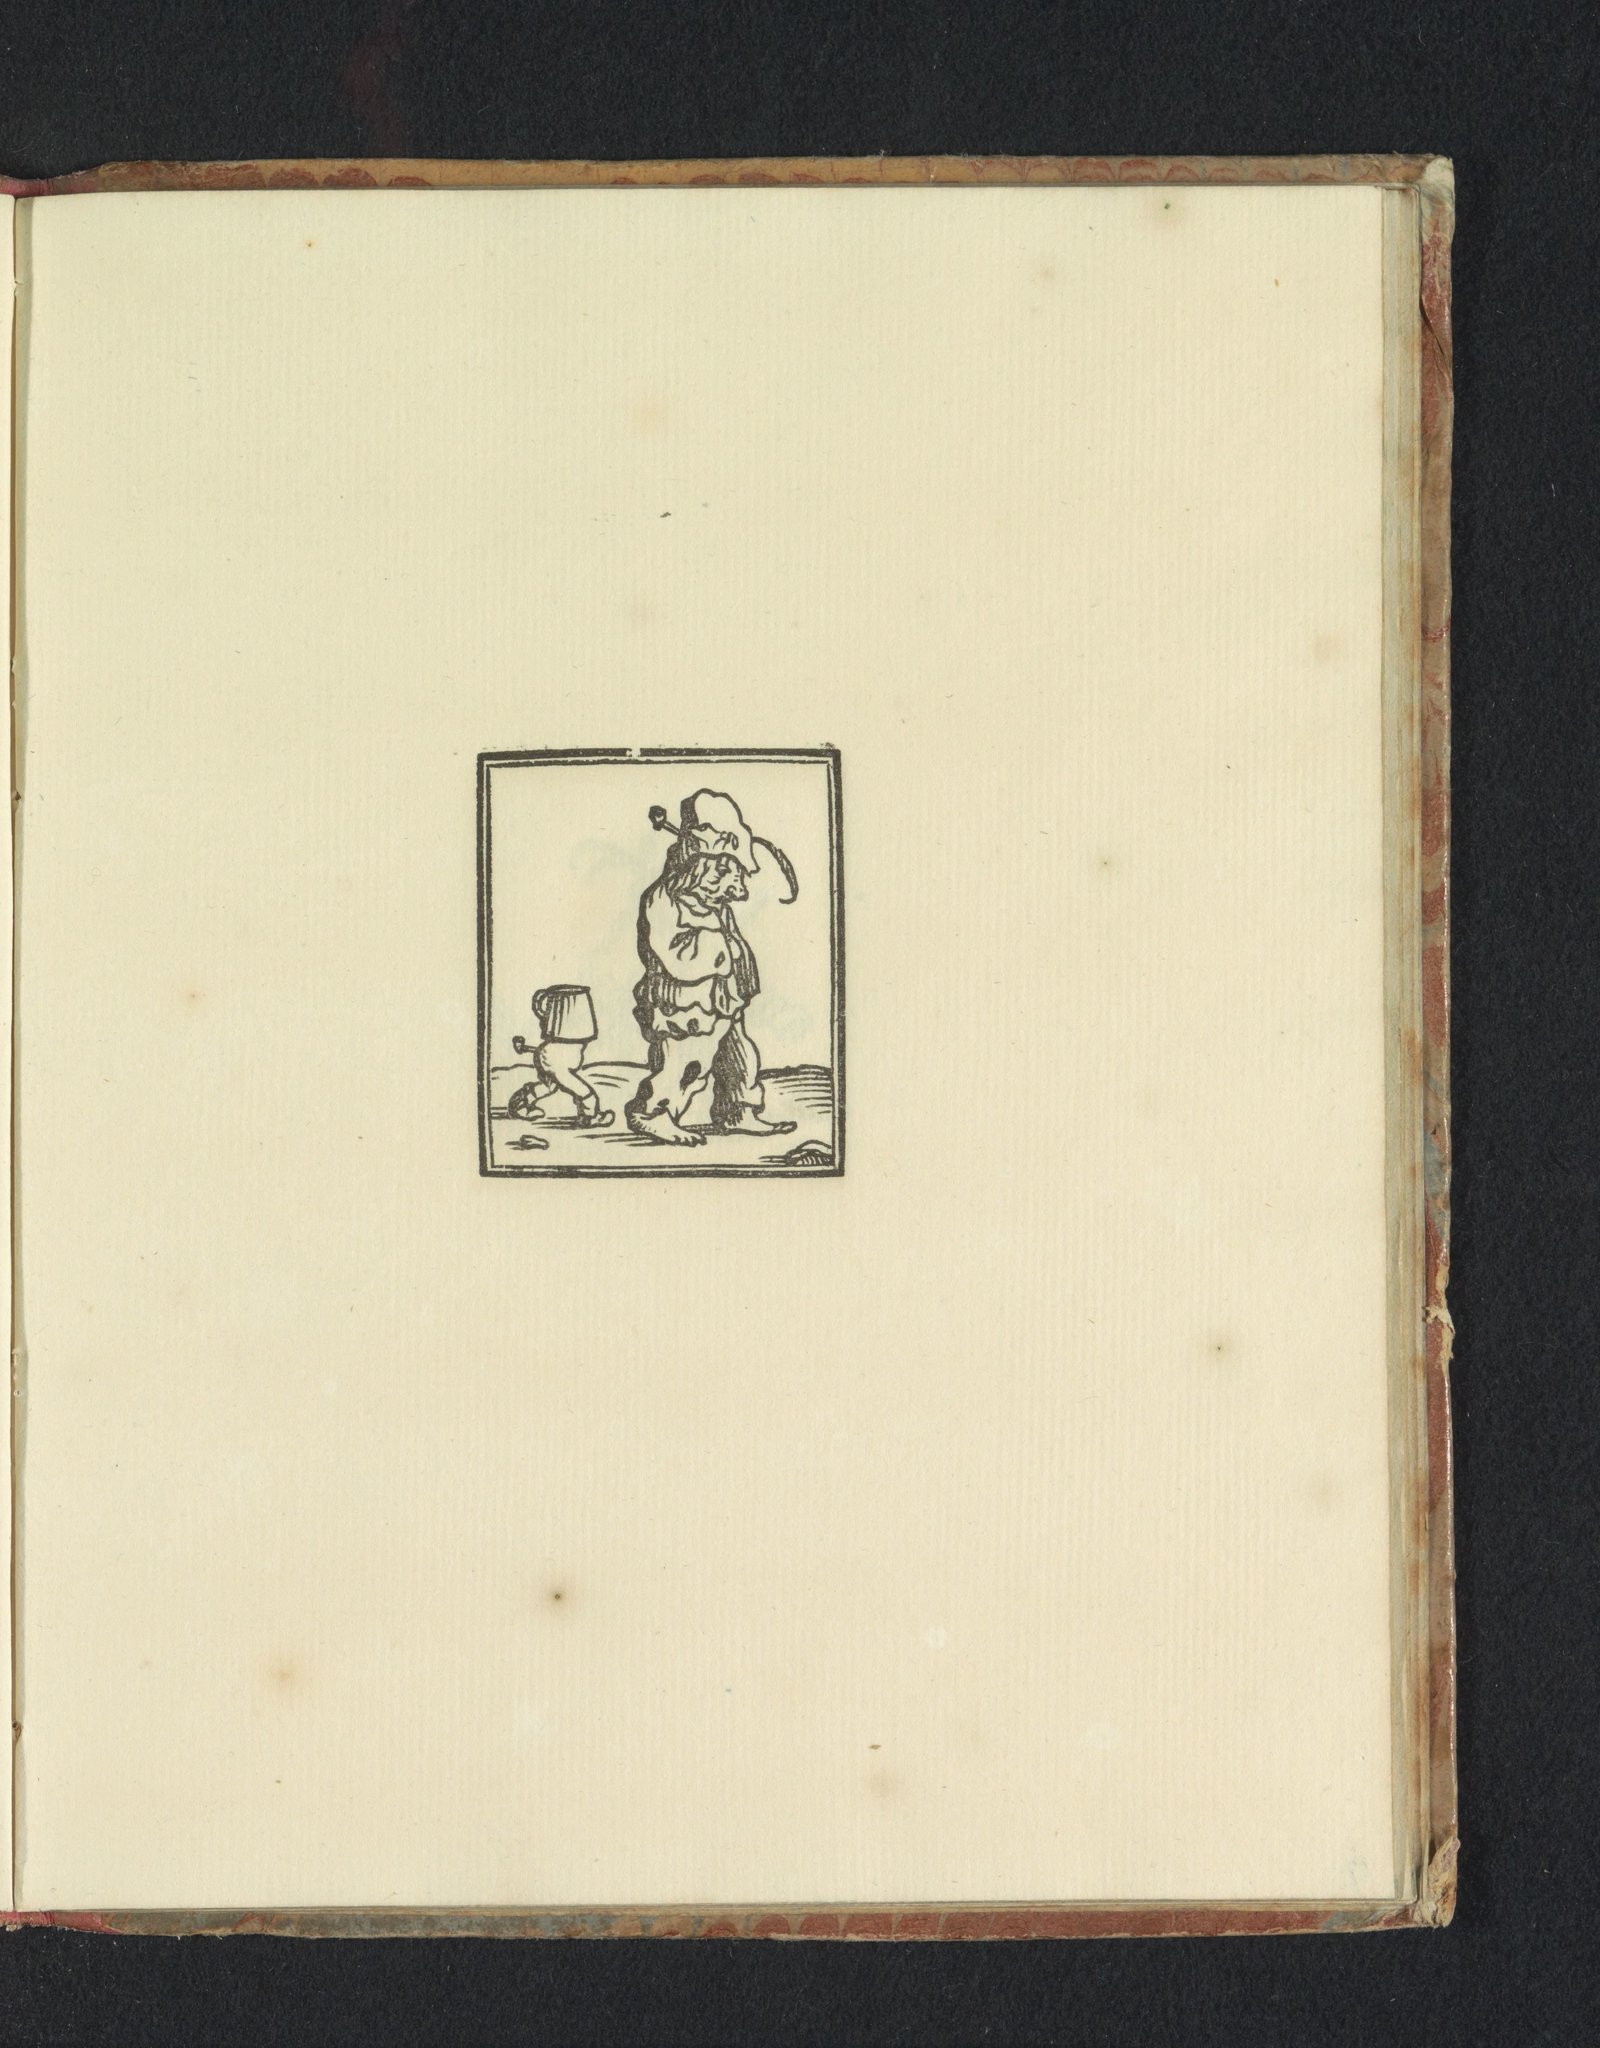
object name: print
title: Jan-rap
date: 1731-1732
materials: paper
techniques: woodcut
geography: haarlem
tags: caricatures (human types)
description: Koddige figuur, in het onderschrift in de overzichtsprent draagt deze figuur de naam: Jan-rap. Onderdeel van het boekje: XXXVI. aartige figuuren, geinventeert door Izaak van Ostade tot Haarlem [1731-1732].